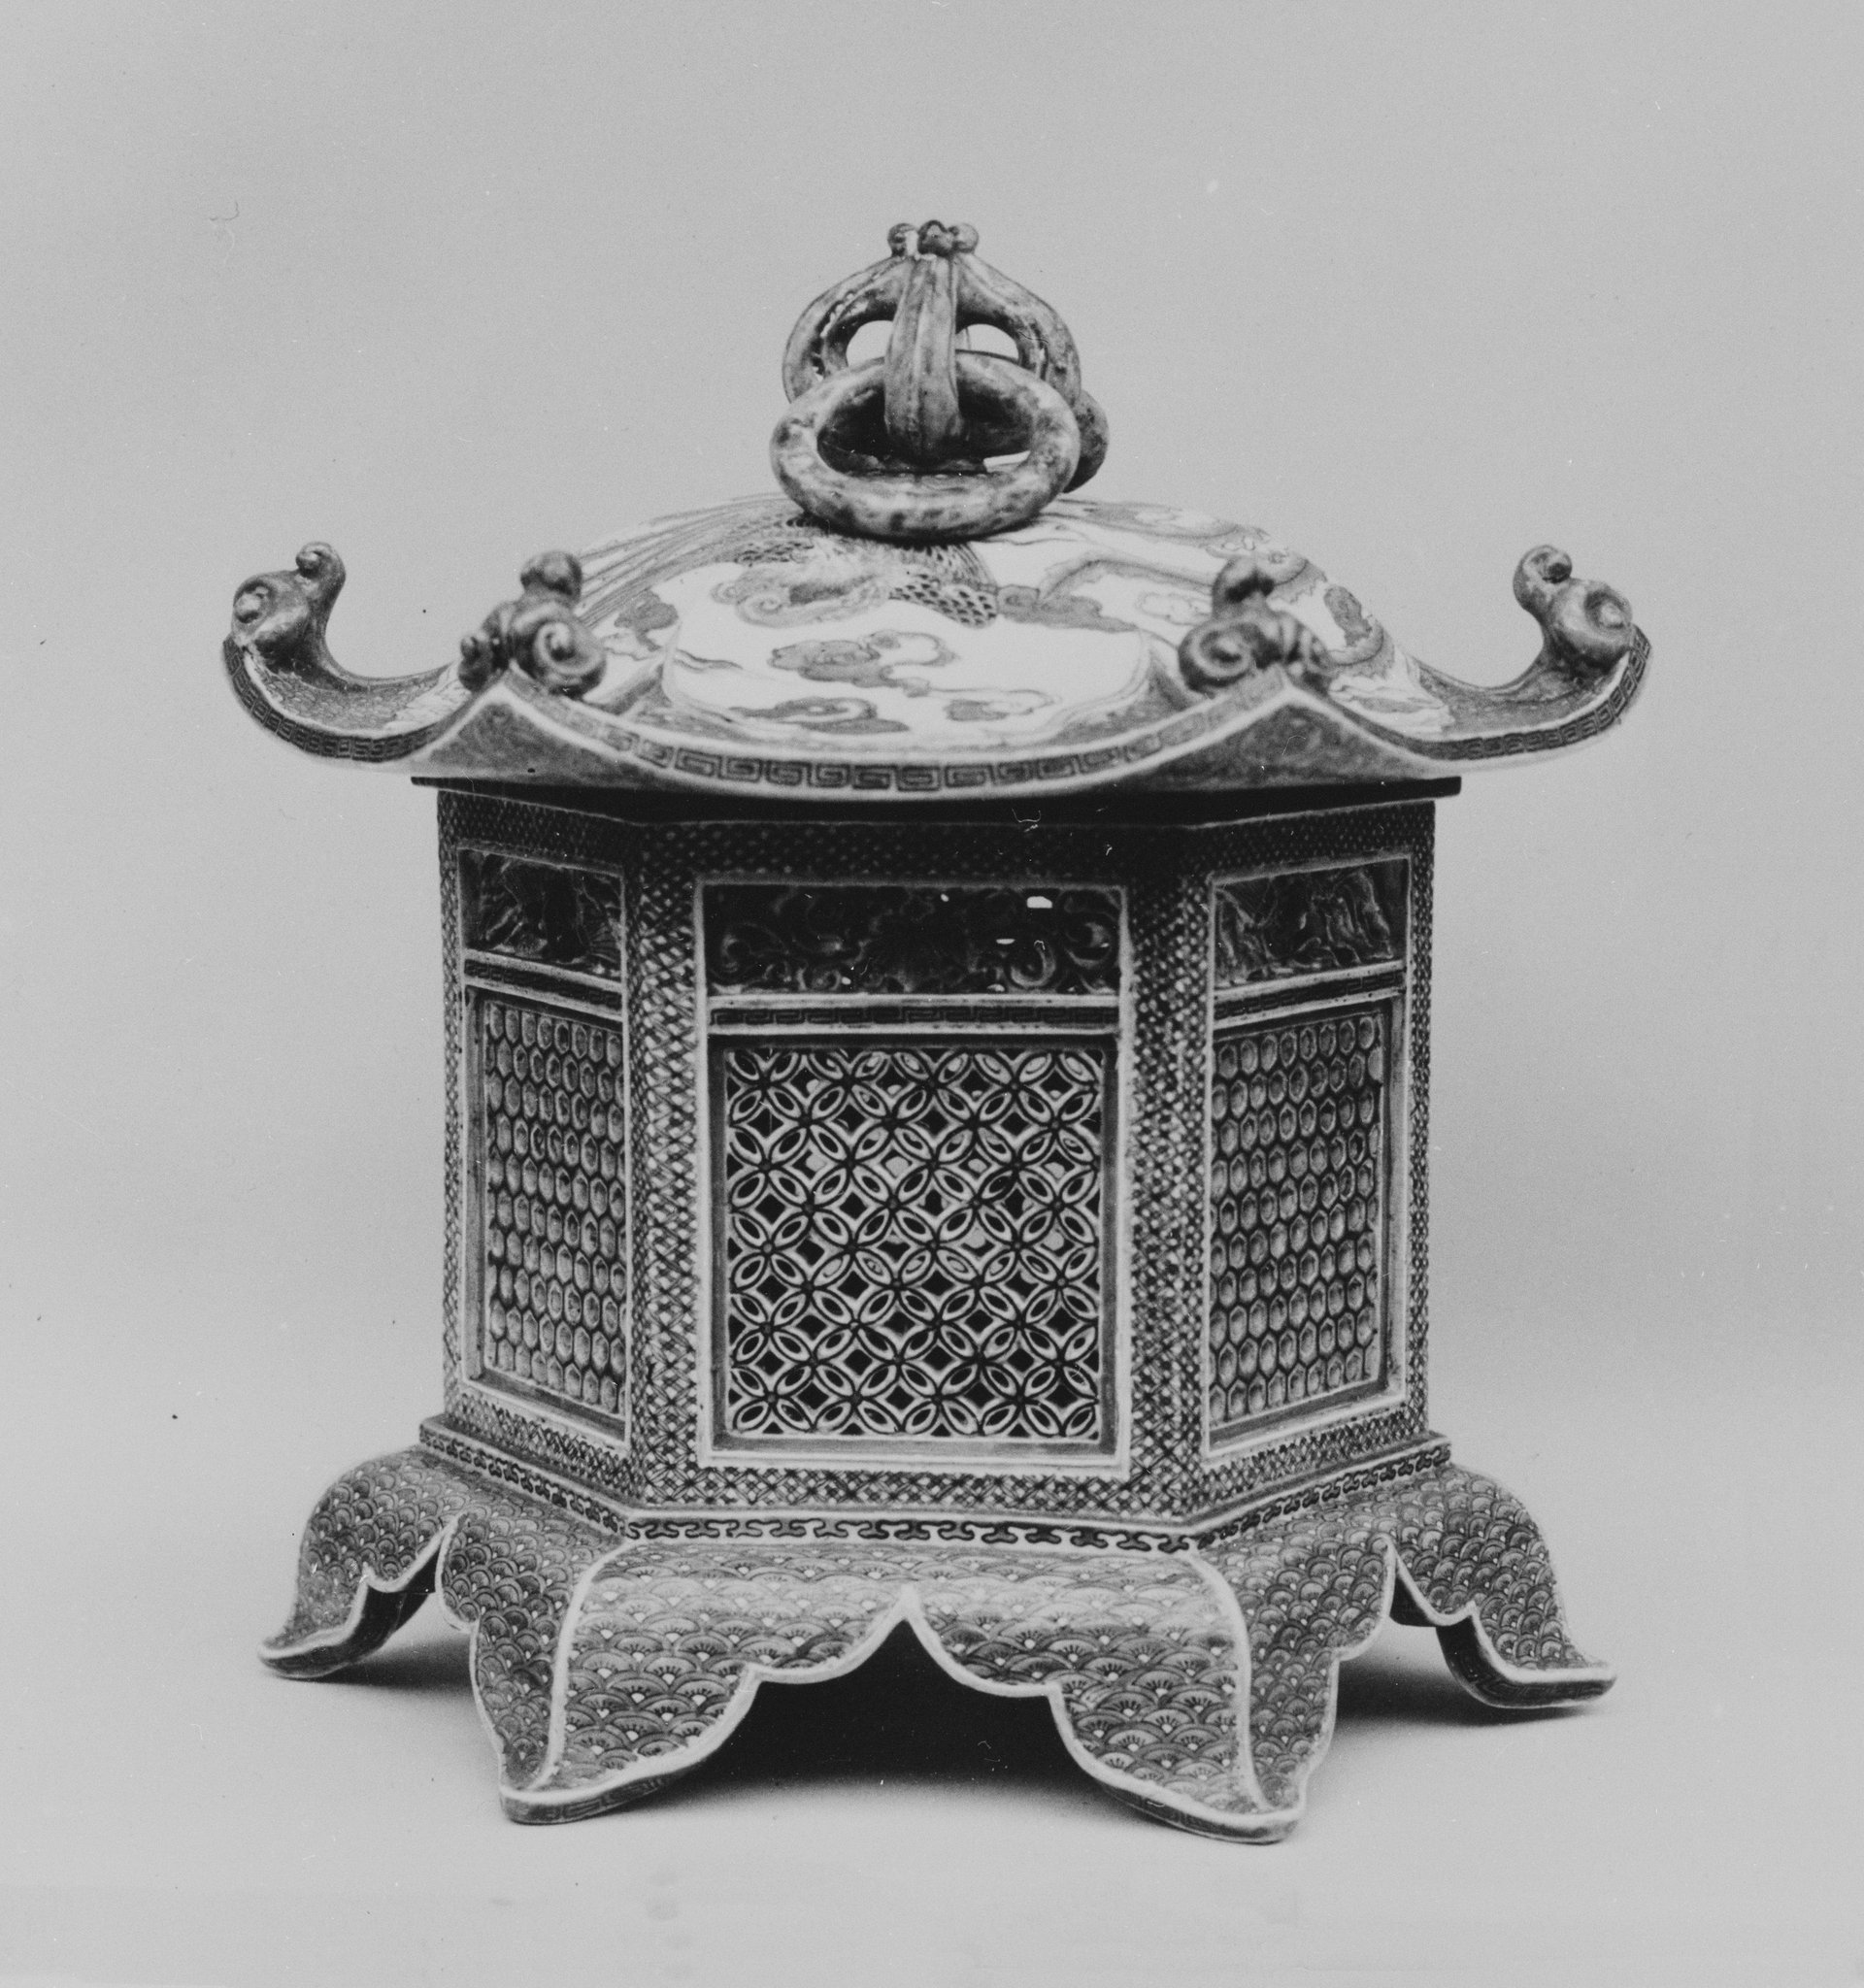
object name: lantern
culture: japanese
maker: genemon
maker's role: artist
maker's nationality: japanese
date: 1850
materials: enamel, glaze, porcelain